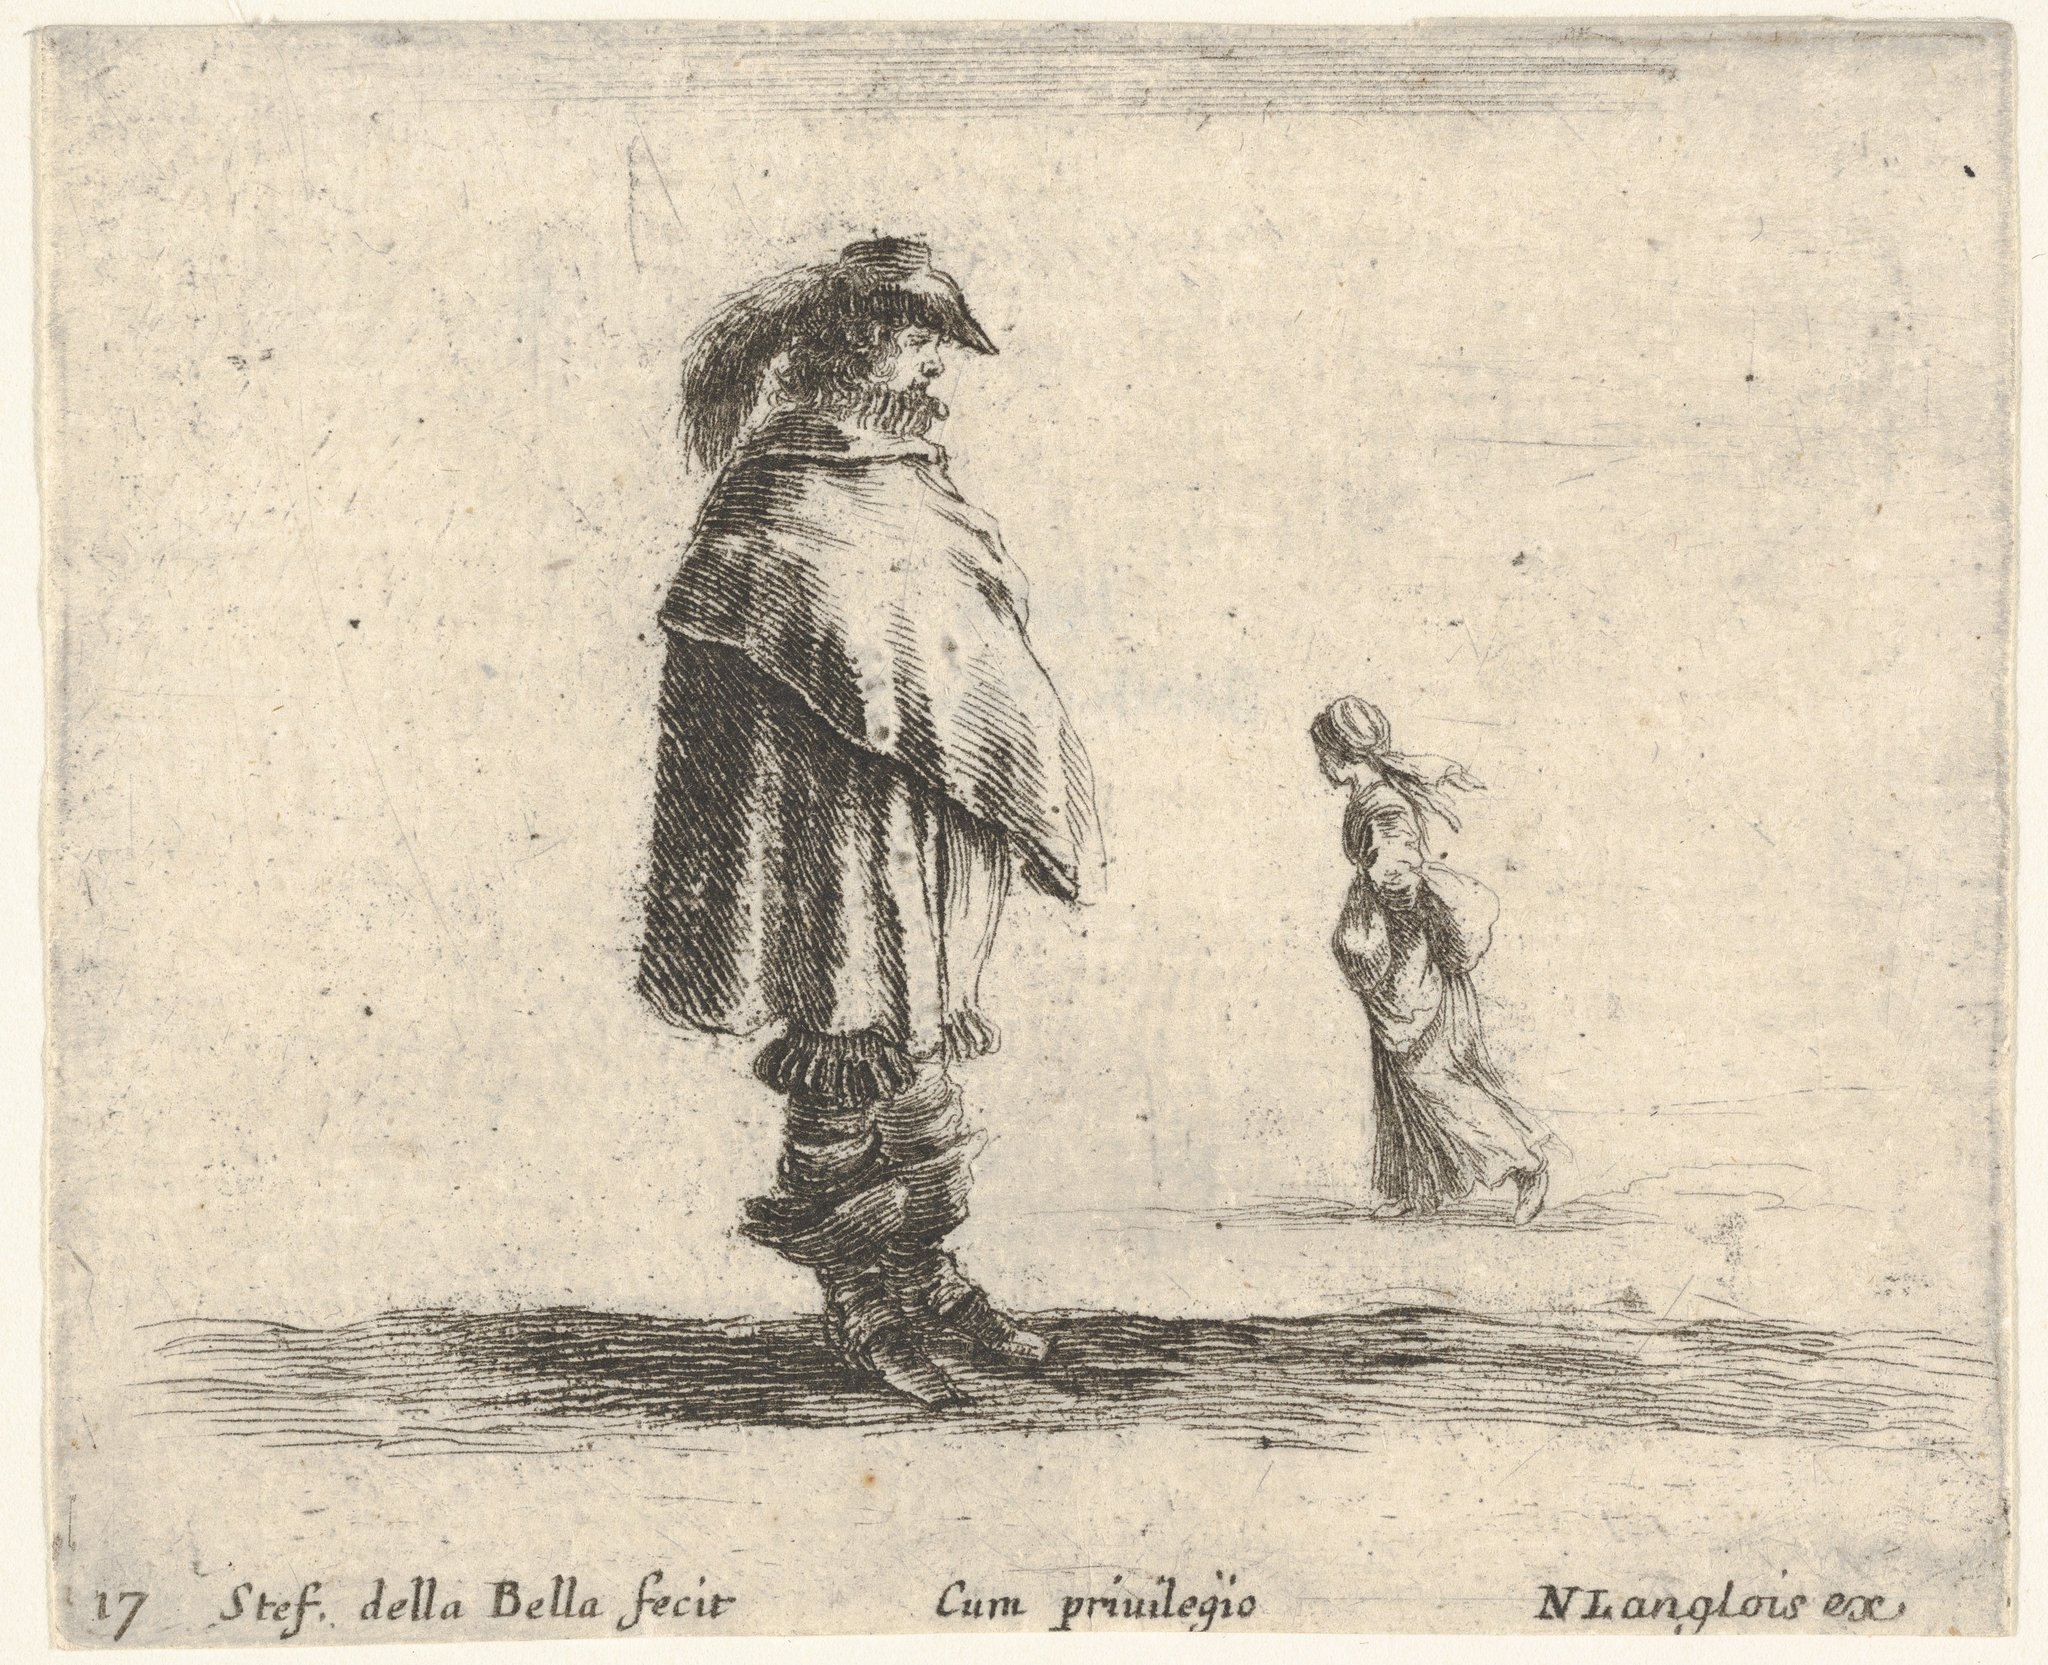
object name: print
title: Plate 17: a man wearing a plumed hat in center facing right, a woman walking towards the left in the background, from "Diversi Capricci"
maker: stefano della bella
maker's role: artist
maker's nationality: italian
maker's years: 1610-1664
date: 1644-1647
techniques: etching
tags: hats,men,women,walking